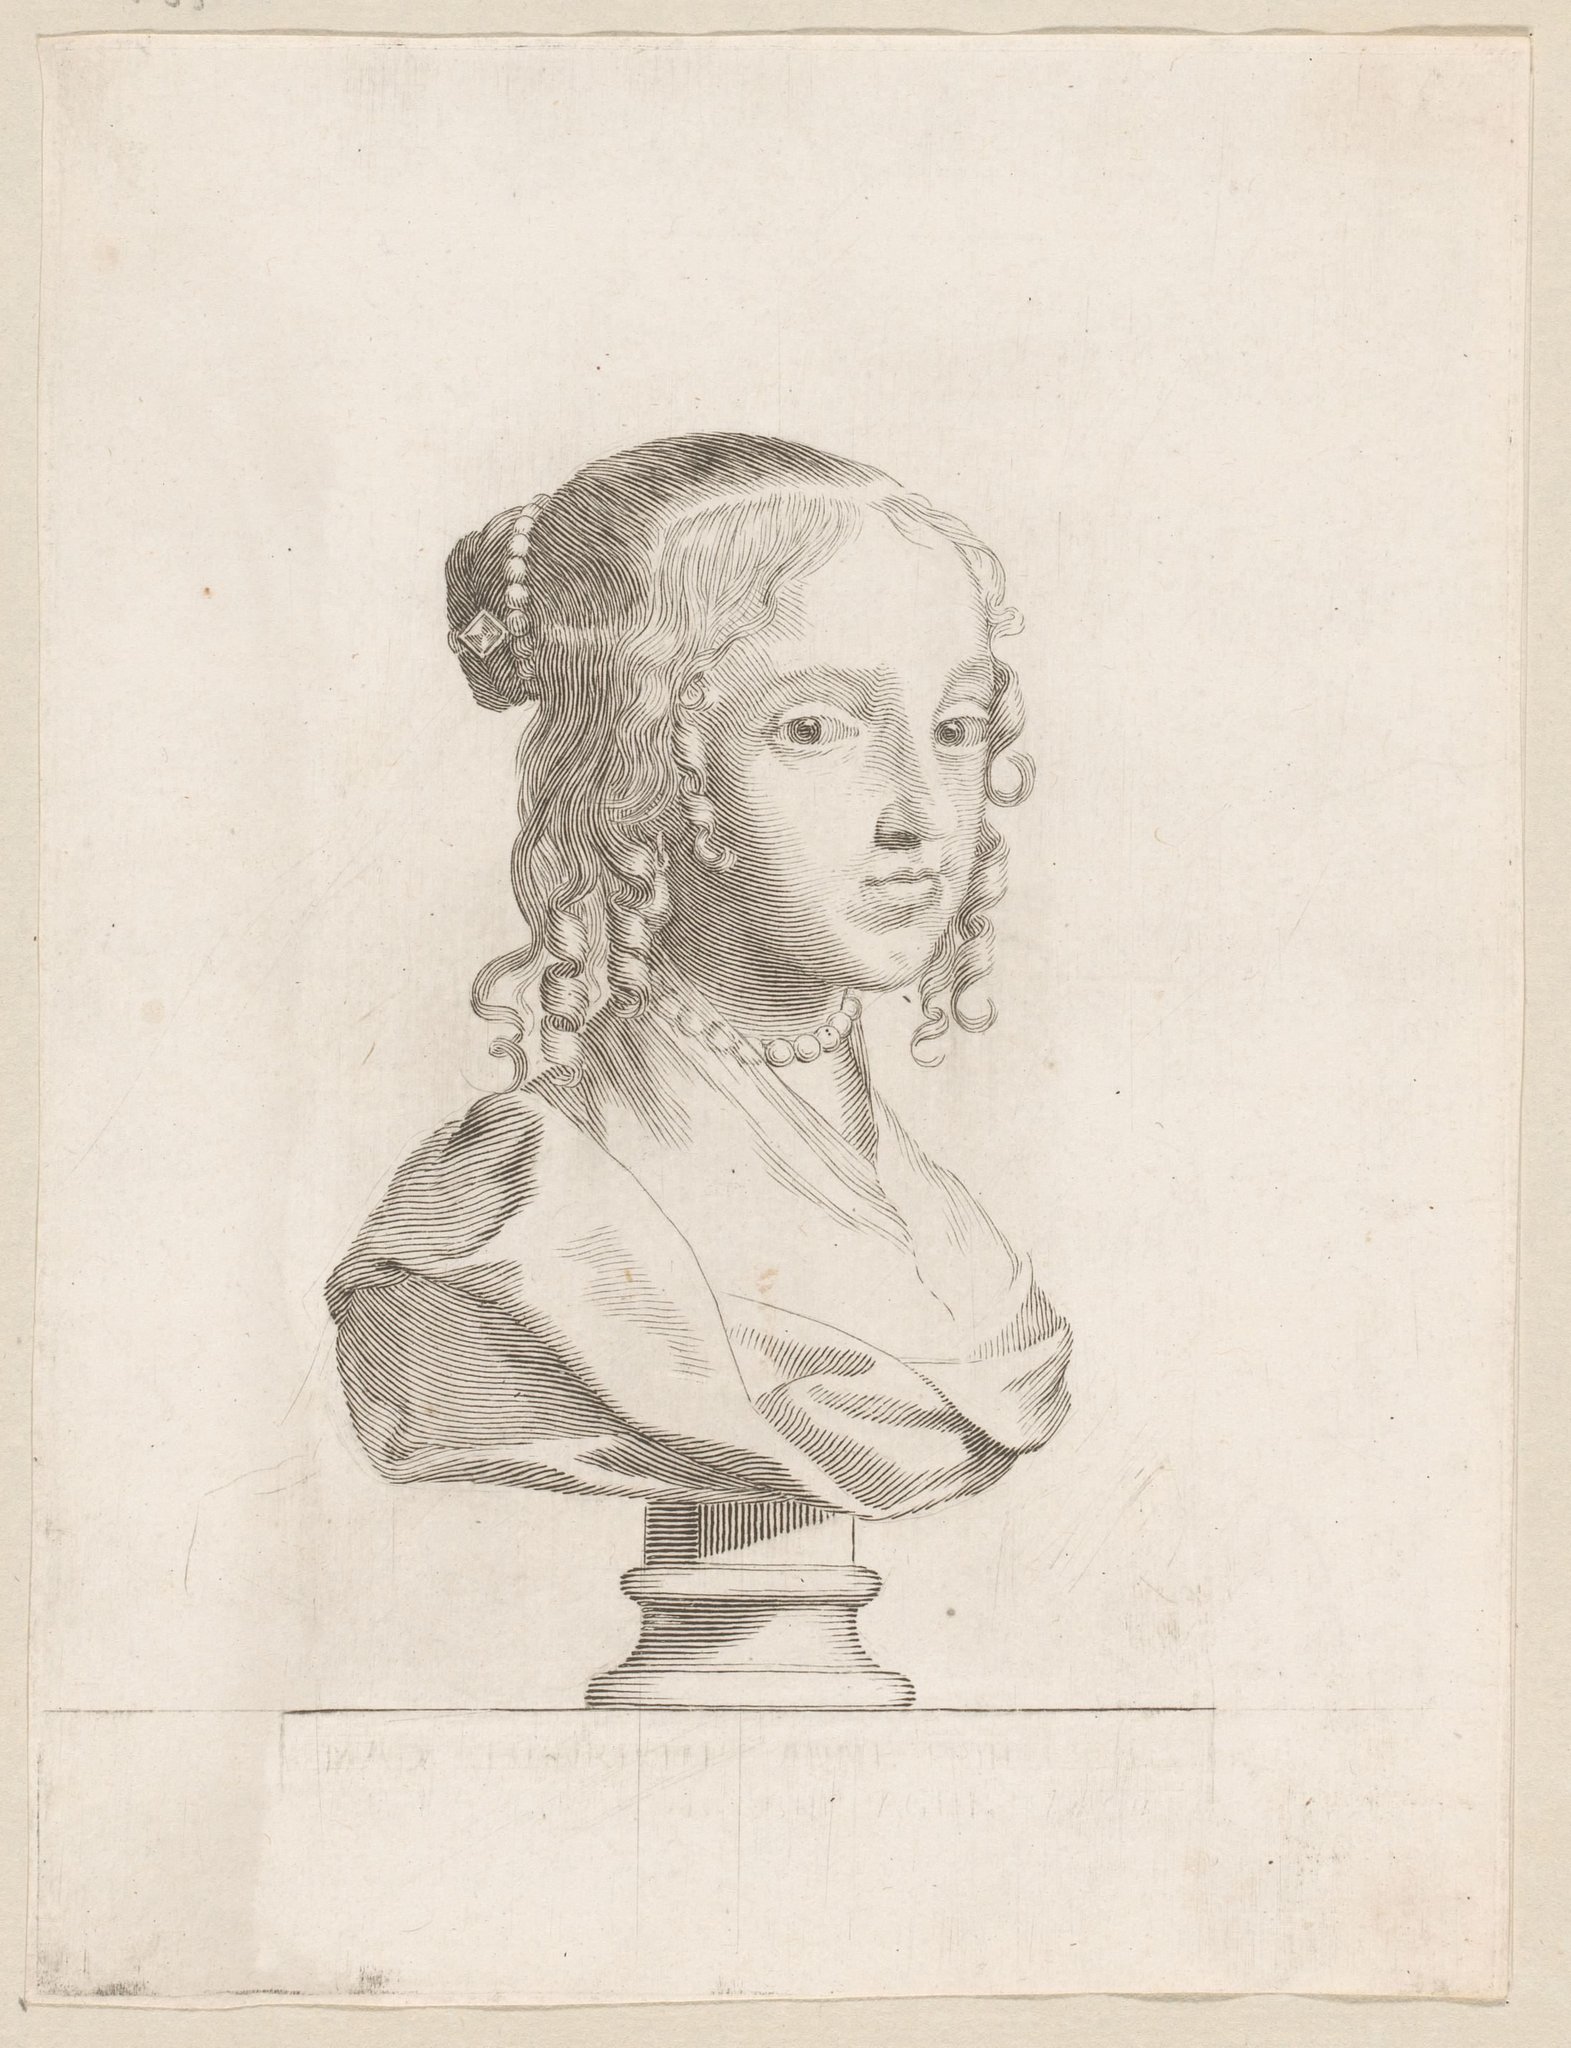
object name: print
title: Portretbuste van Henriëtta Anne van Engeland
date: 1655-1750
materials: paper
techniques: engraving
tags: historical persons, piece of sculpture, reproduction of a piece of sculpture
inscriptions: collector's mark: Lugt 240